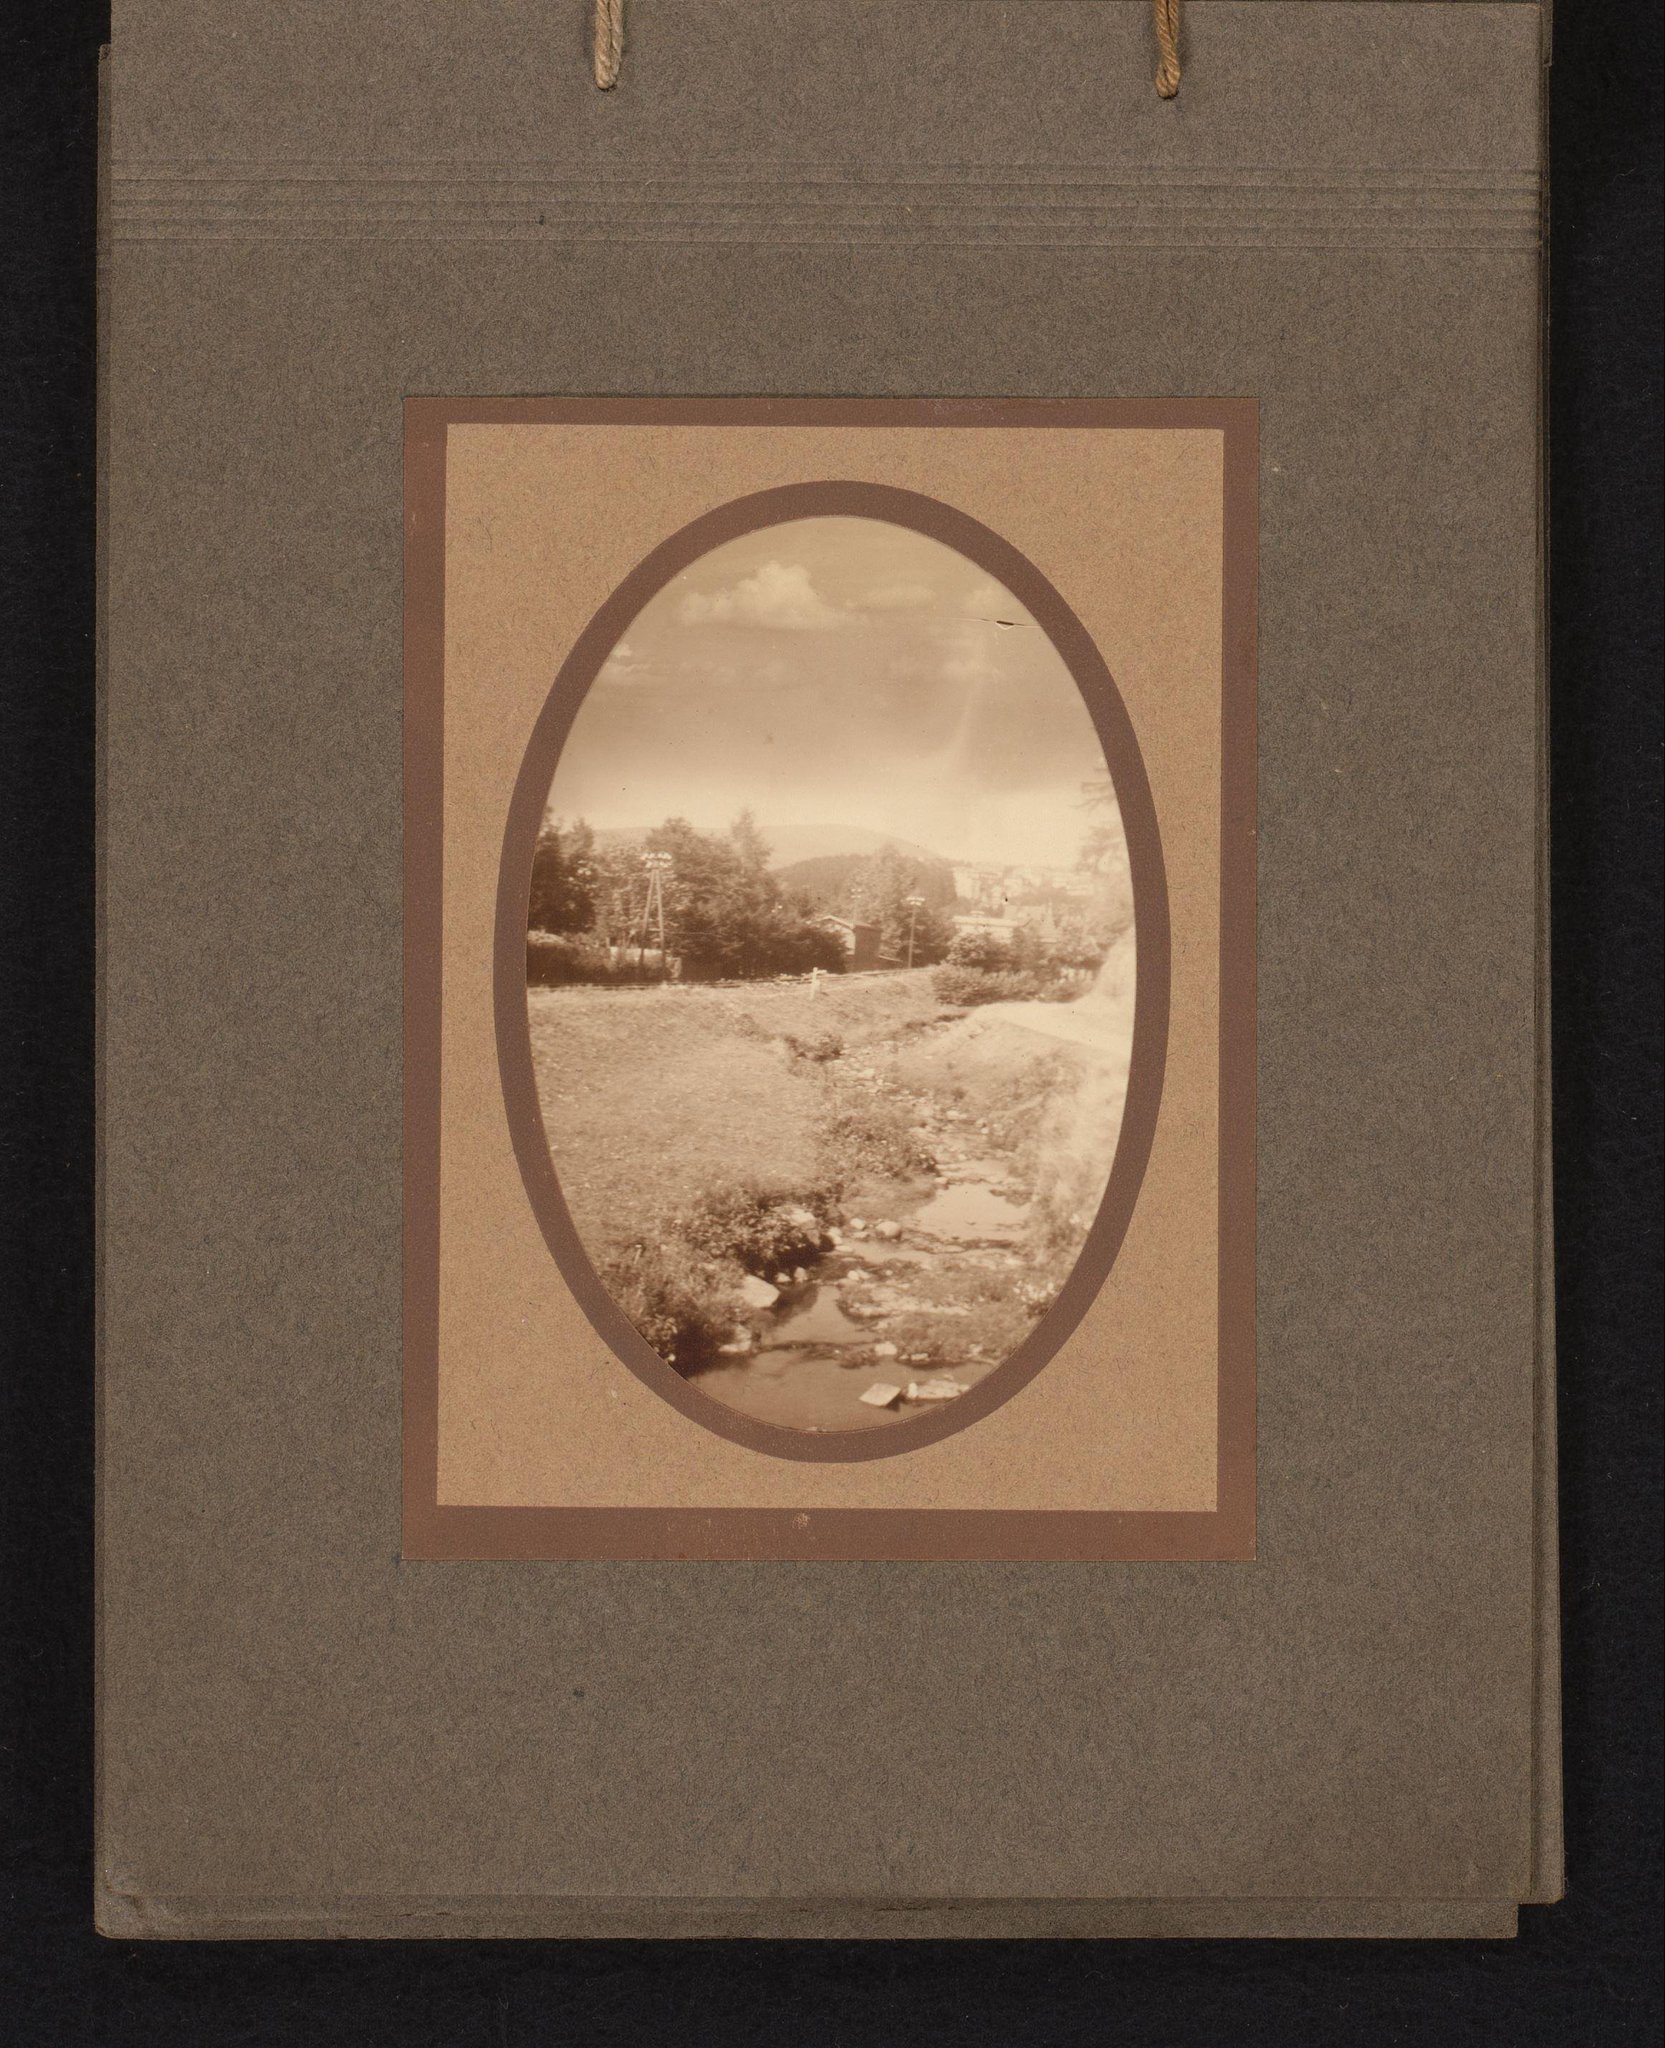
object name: photograph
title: Landschap met een beek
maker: Anonymous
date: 1880-1930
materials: cardboard, photographic support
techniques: collodion silver print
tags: city-view, and landscape with man-made constructions - ii - ideal landscapes, brook